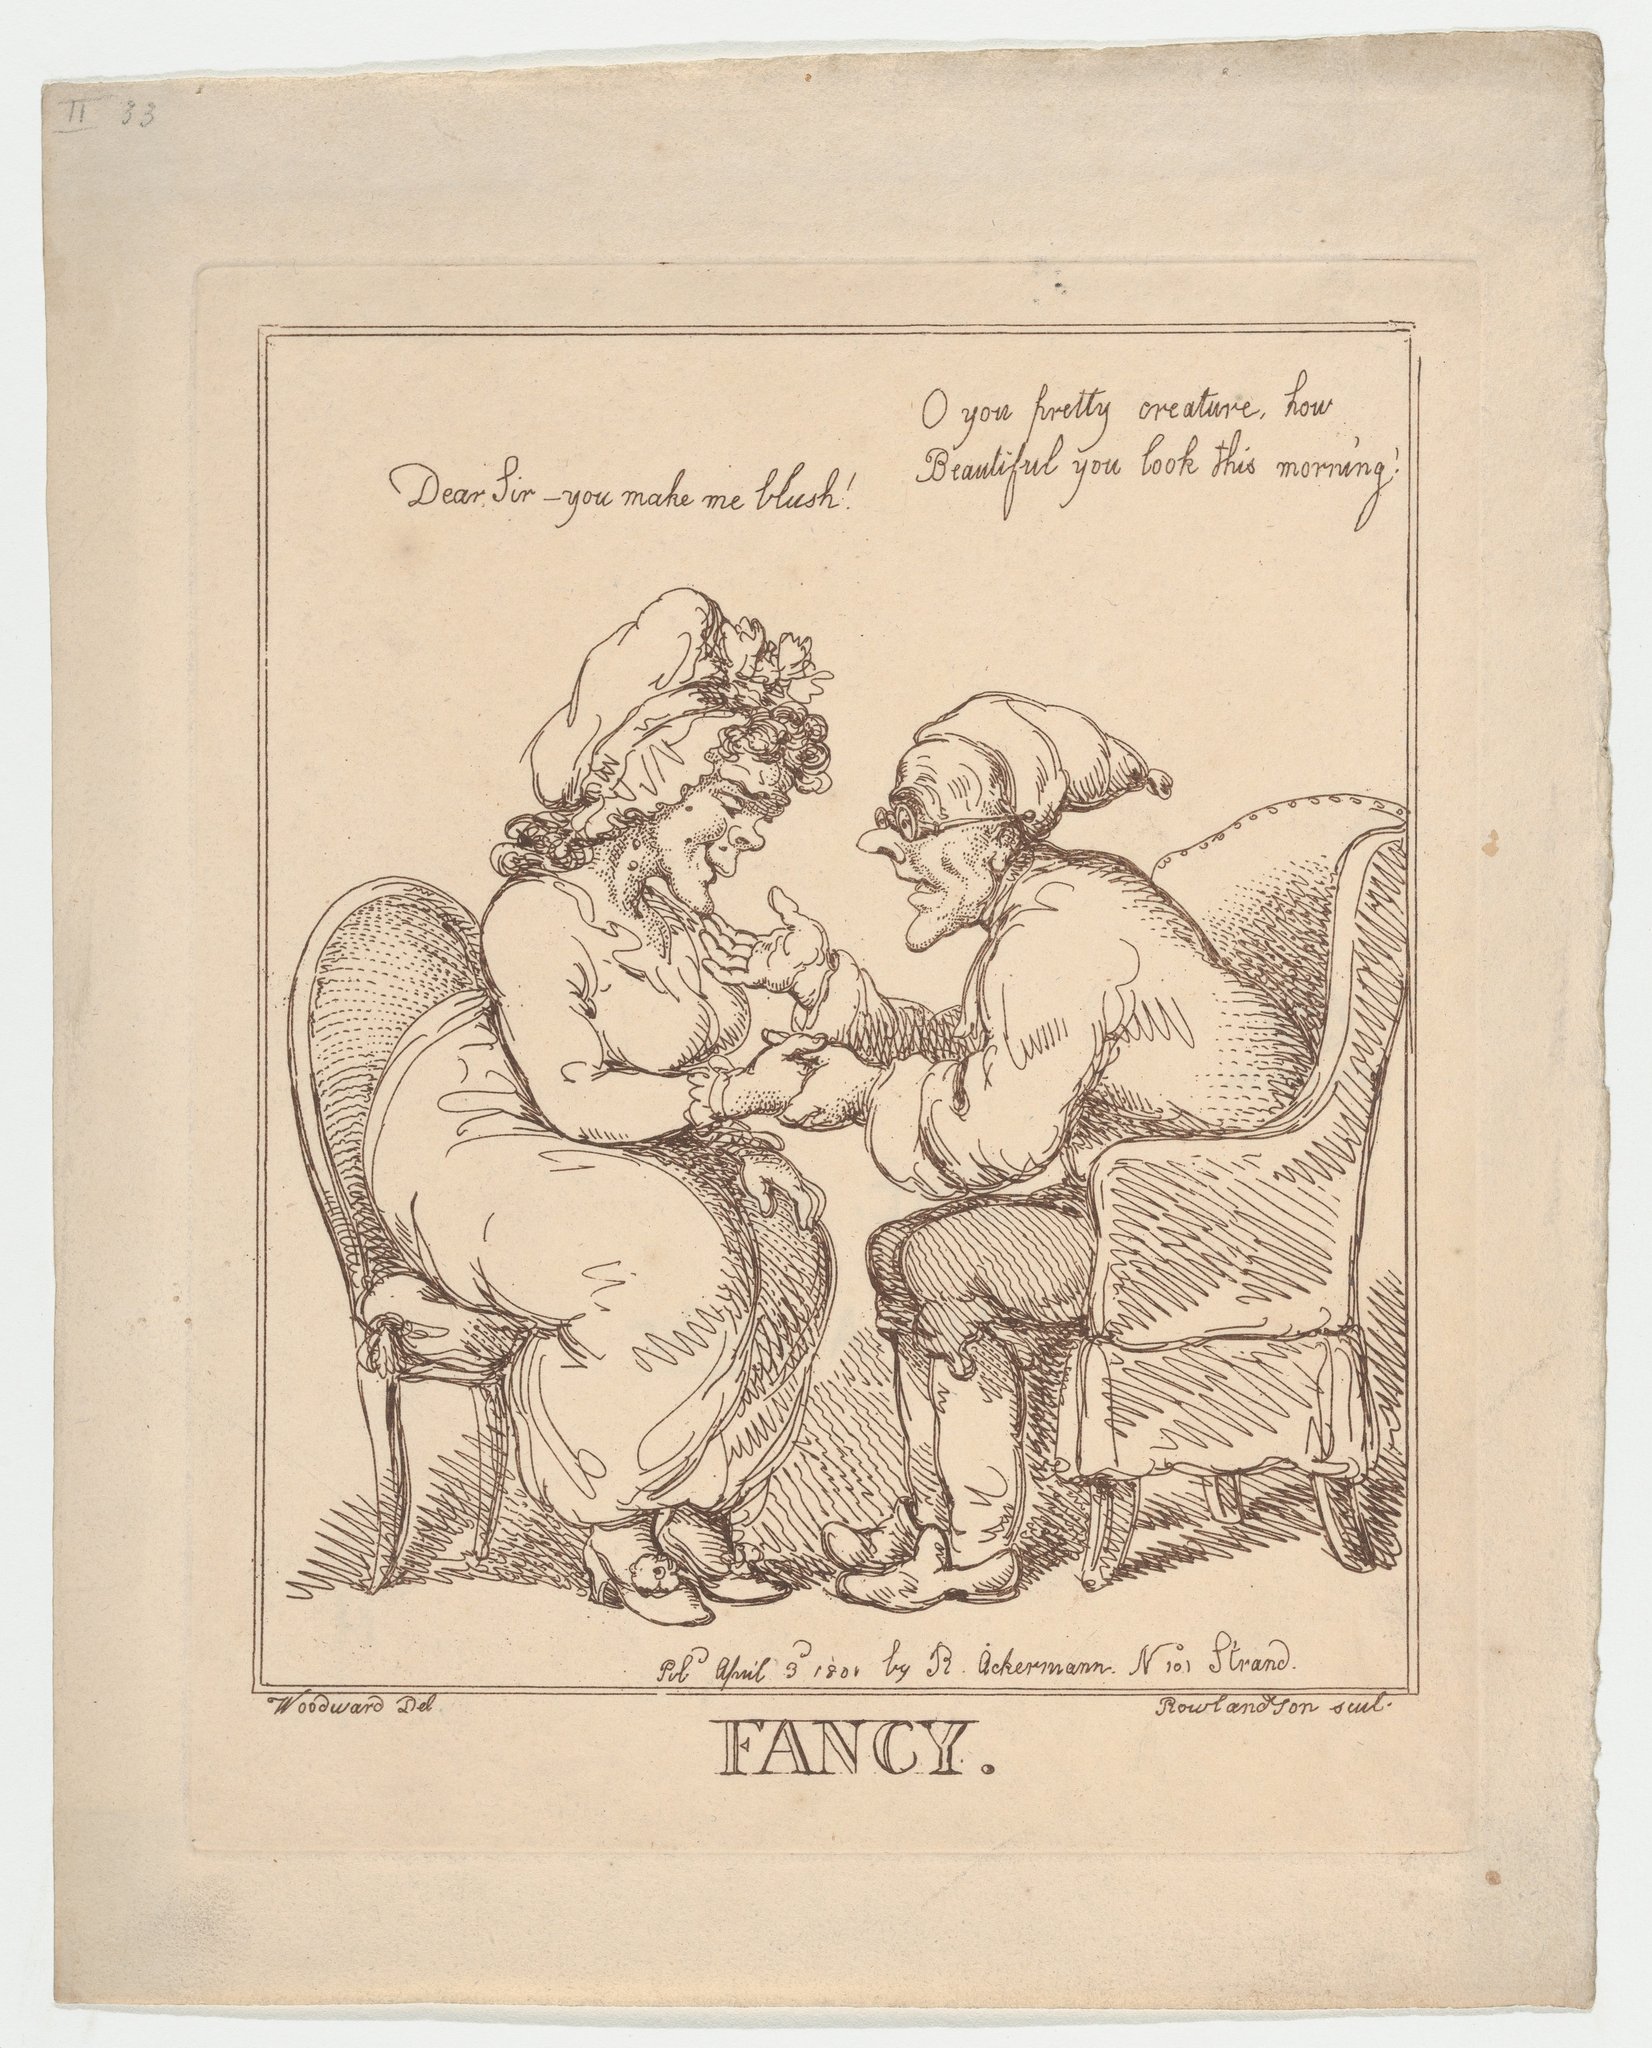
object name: print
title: Fancy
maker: thomas rowlandson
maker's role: artist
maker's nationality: british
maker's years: 1757-1827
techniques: etching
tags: men,profiles,women